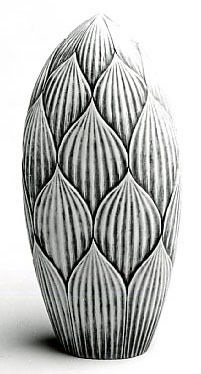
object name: shrine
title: Lotus Shrine Containing Bodhisattva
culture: chinese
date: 1701-1800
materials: ivory